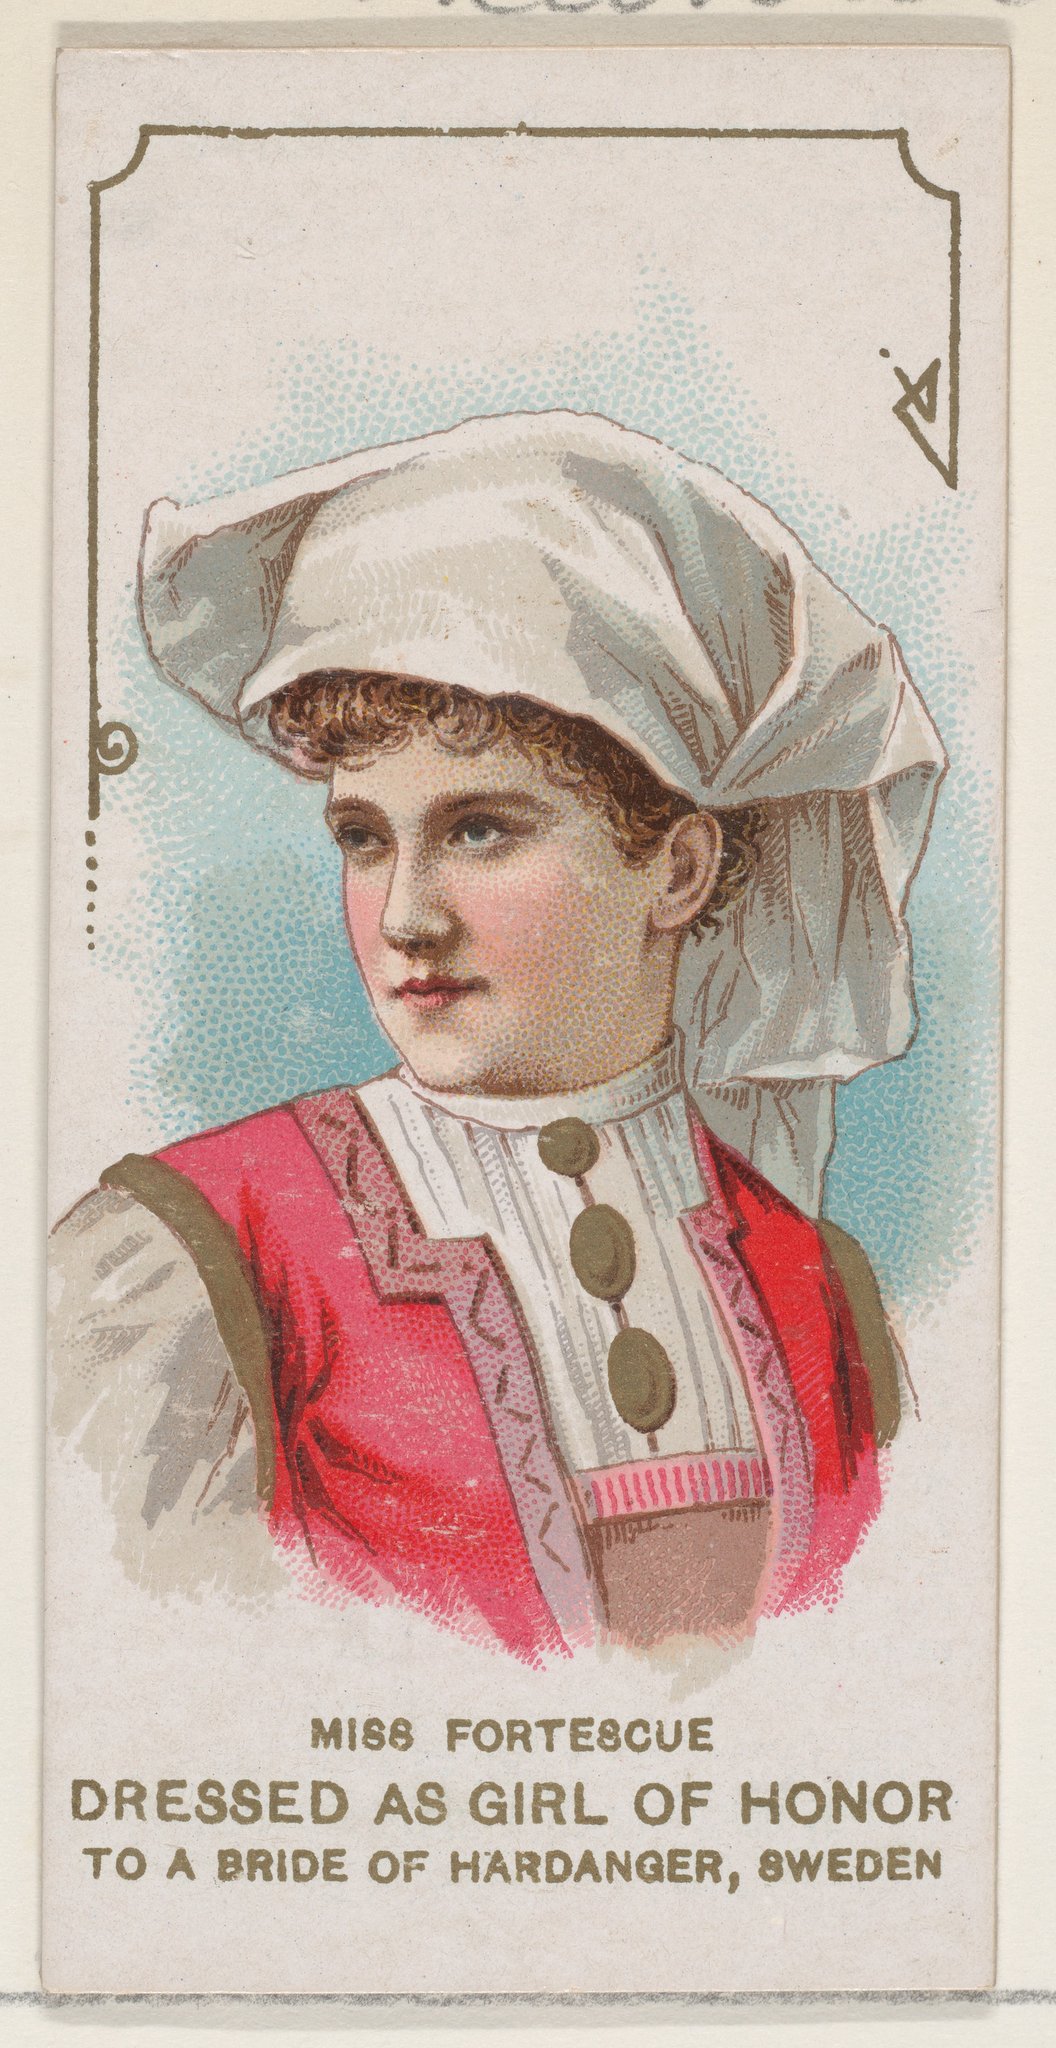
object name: print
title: Miss Fortescue Dressed as Girl of Honor to a Bride of Hardanger, Sweden, from the set Actors and Actresses, First Series (N70) for Duke brand cigarettes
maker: w. duke, sons & co.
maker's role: publisher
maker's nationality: american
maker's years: 1870-1920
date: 1888-1889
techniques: color lithograph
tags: women,actresses